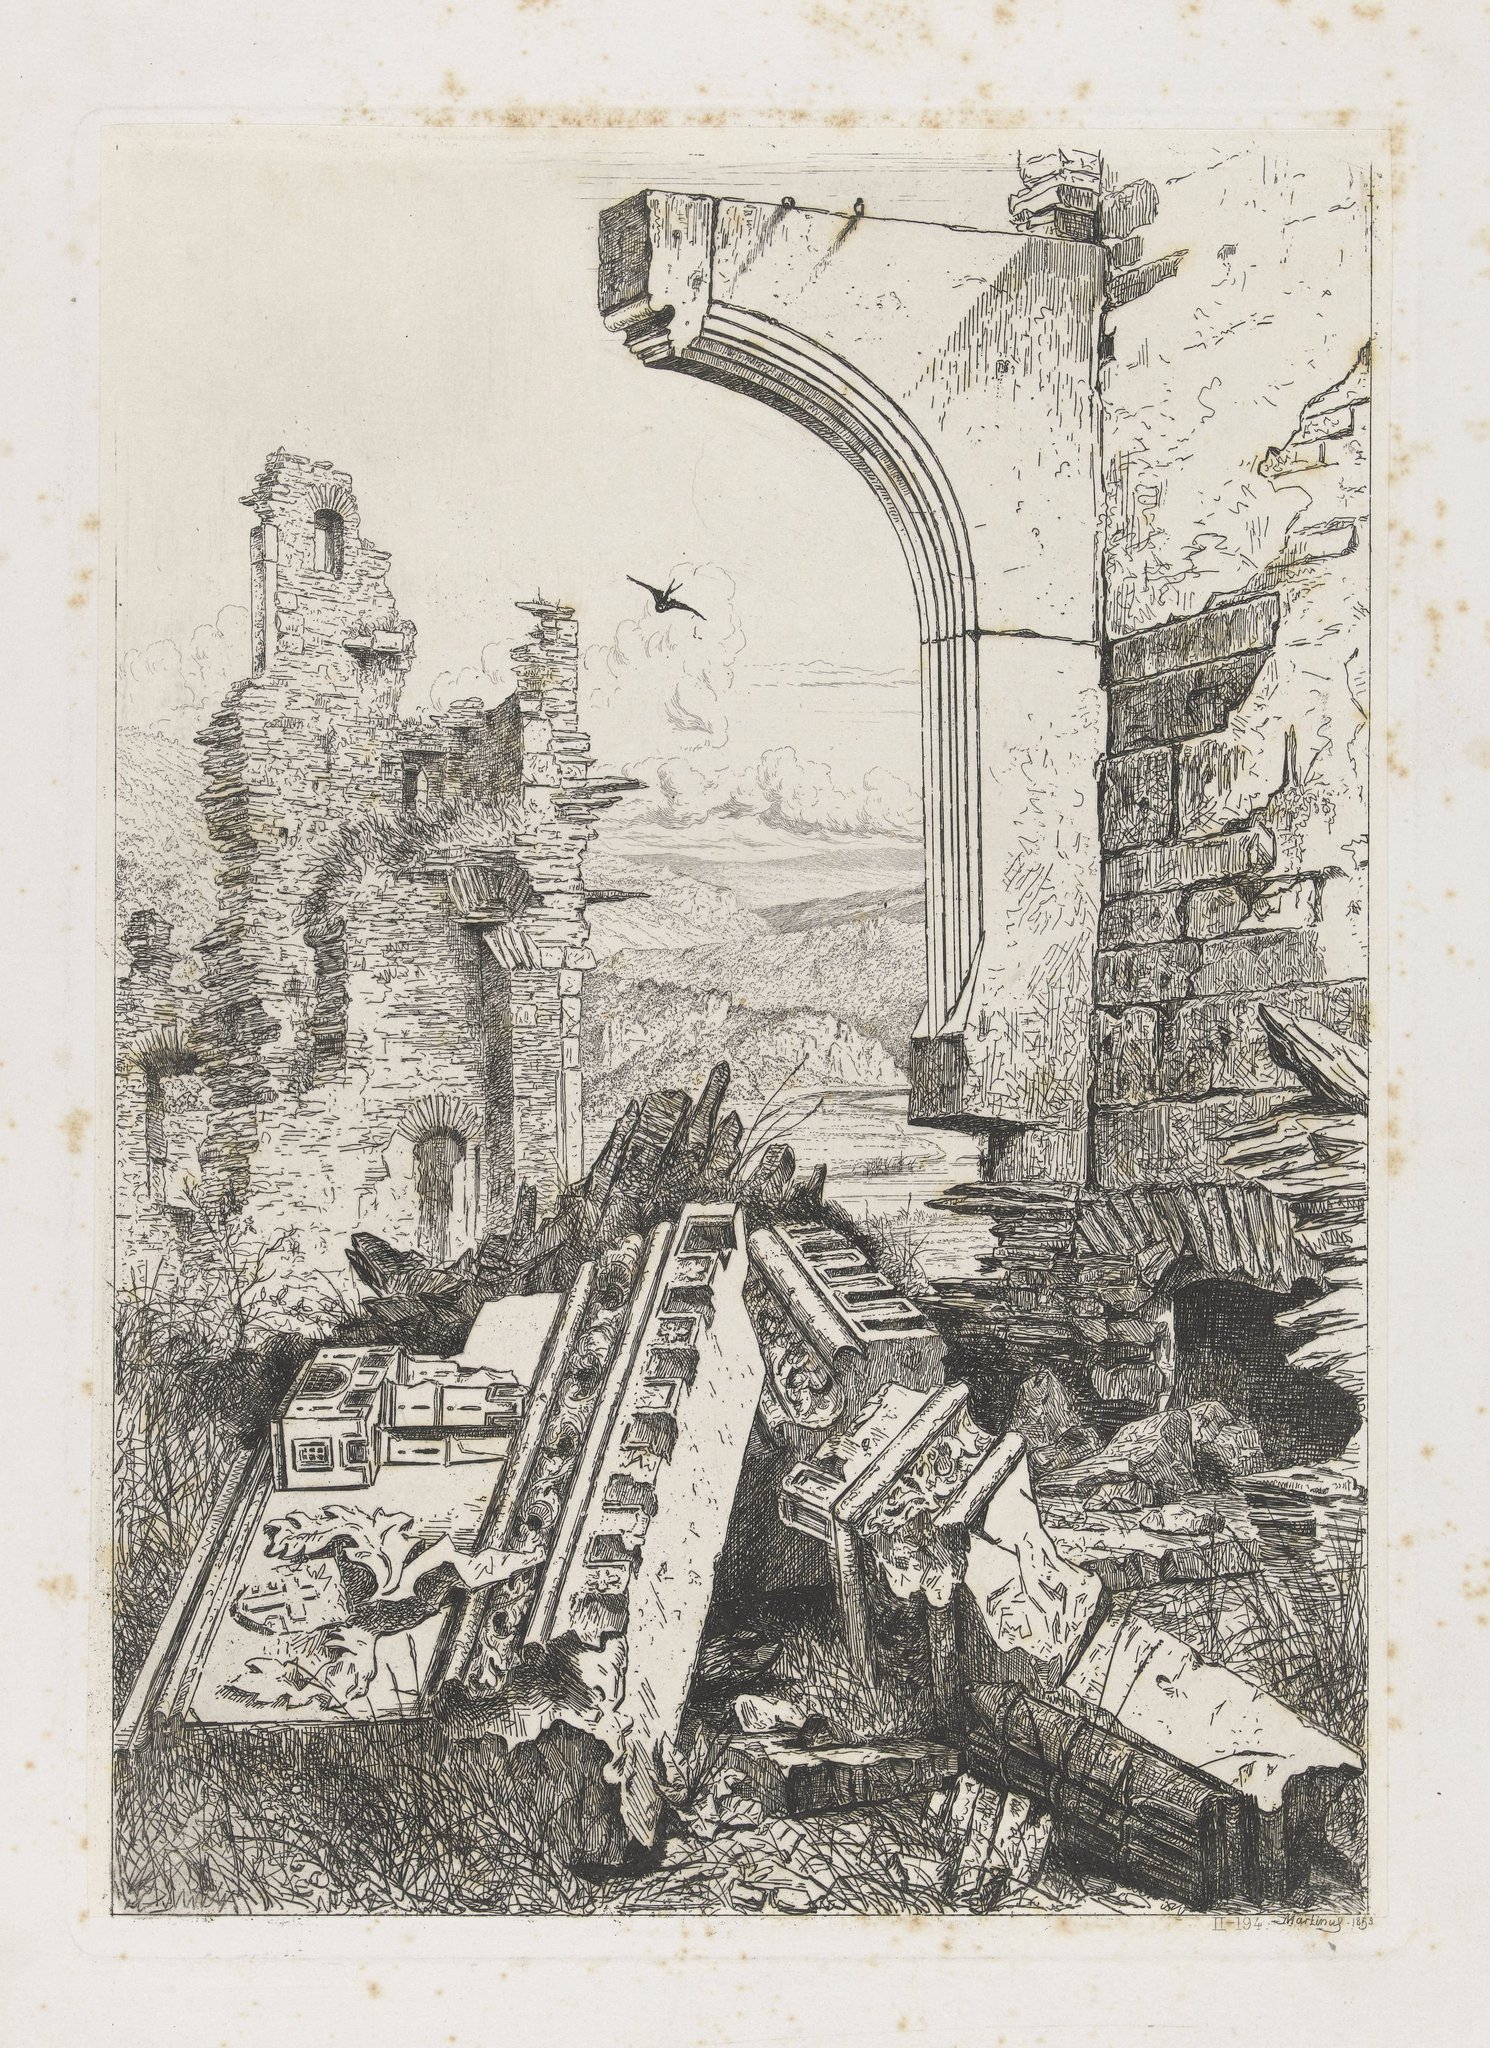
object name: print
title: Ruïne van kasteel Bourscheid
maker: martinus antonius kuytenbrouwer jr.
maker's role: draughtsman, painter, print maker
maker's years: 1821-1897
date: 1853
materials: paper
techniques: drypoint, etching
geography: brussels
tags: river, song-birds: swallow, landscape with ruins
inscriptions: collector's mark: Lugt 1485, collector's mark: Lugt 2228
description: In een heuvelachtig landschap vliegt een zwaluw boven de ruïne van kasteel Bourscheid, gelegen aan de rivier de Sûre.